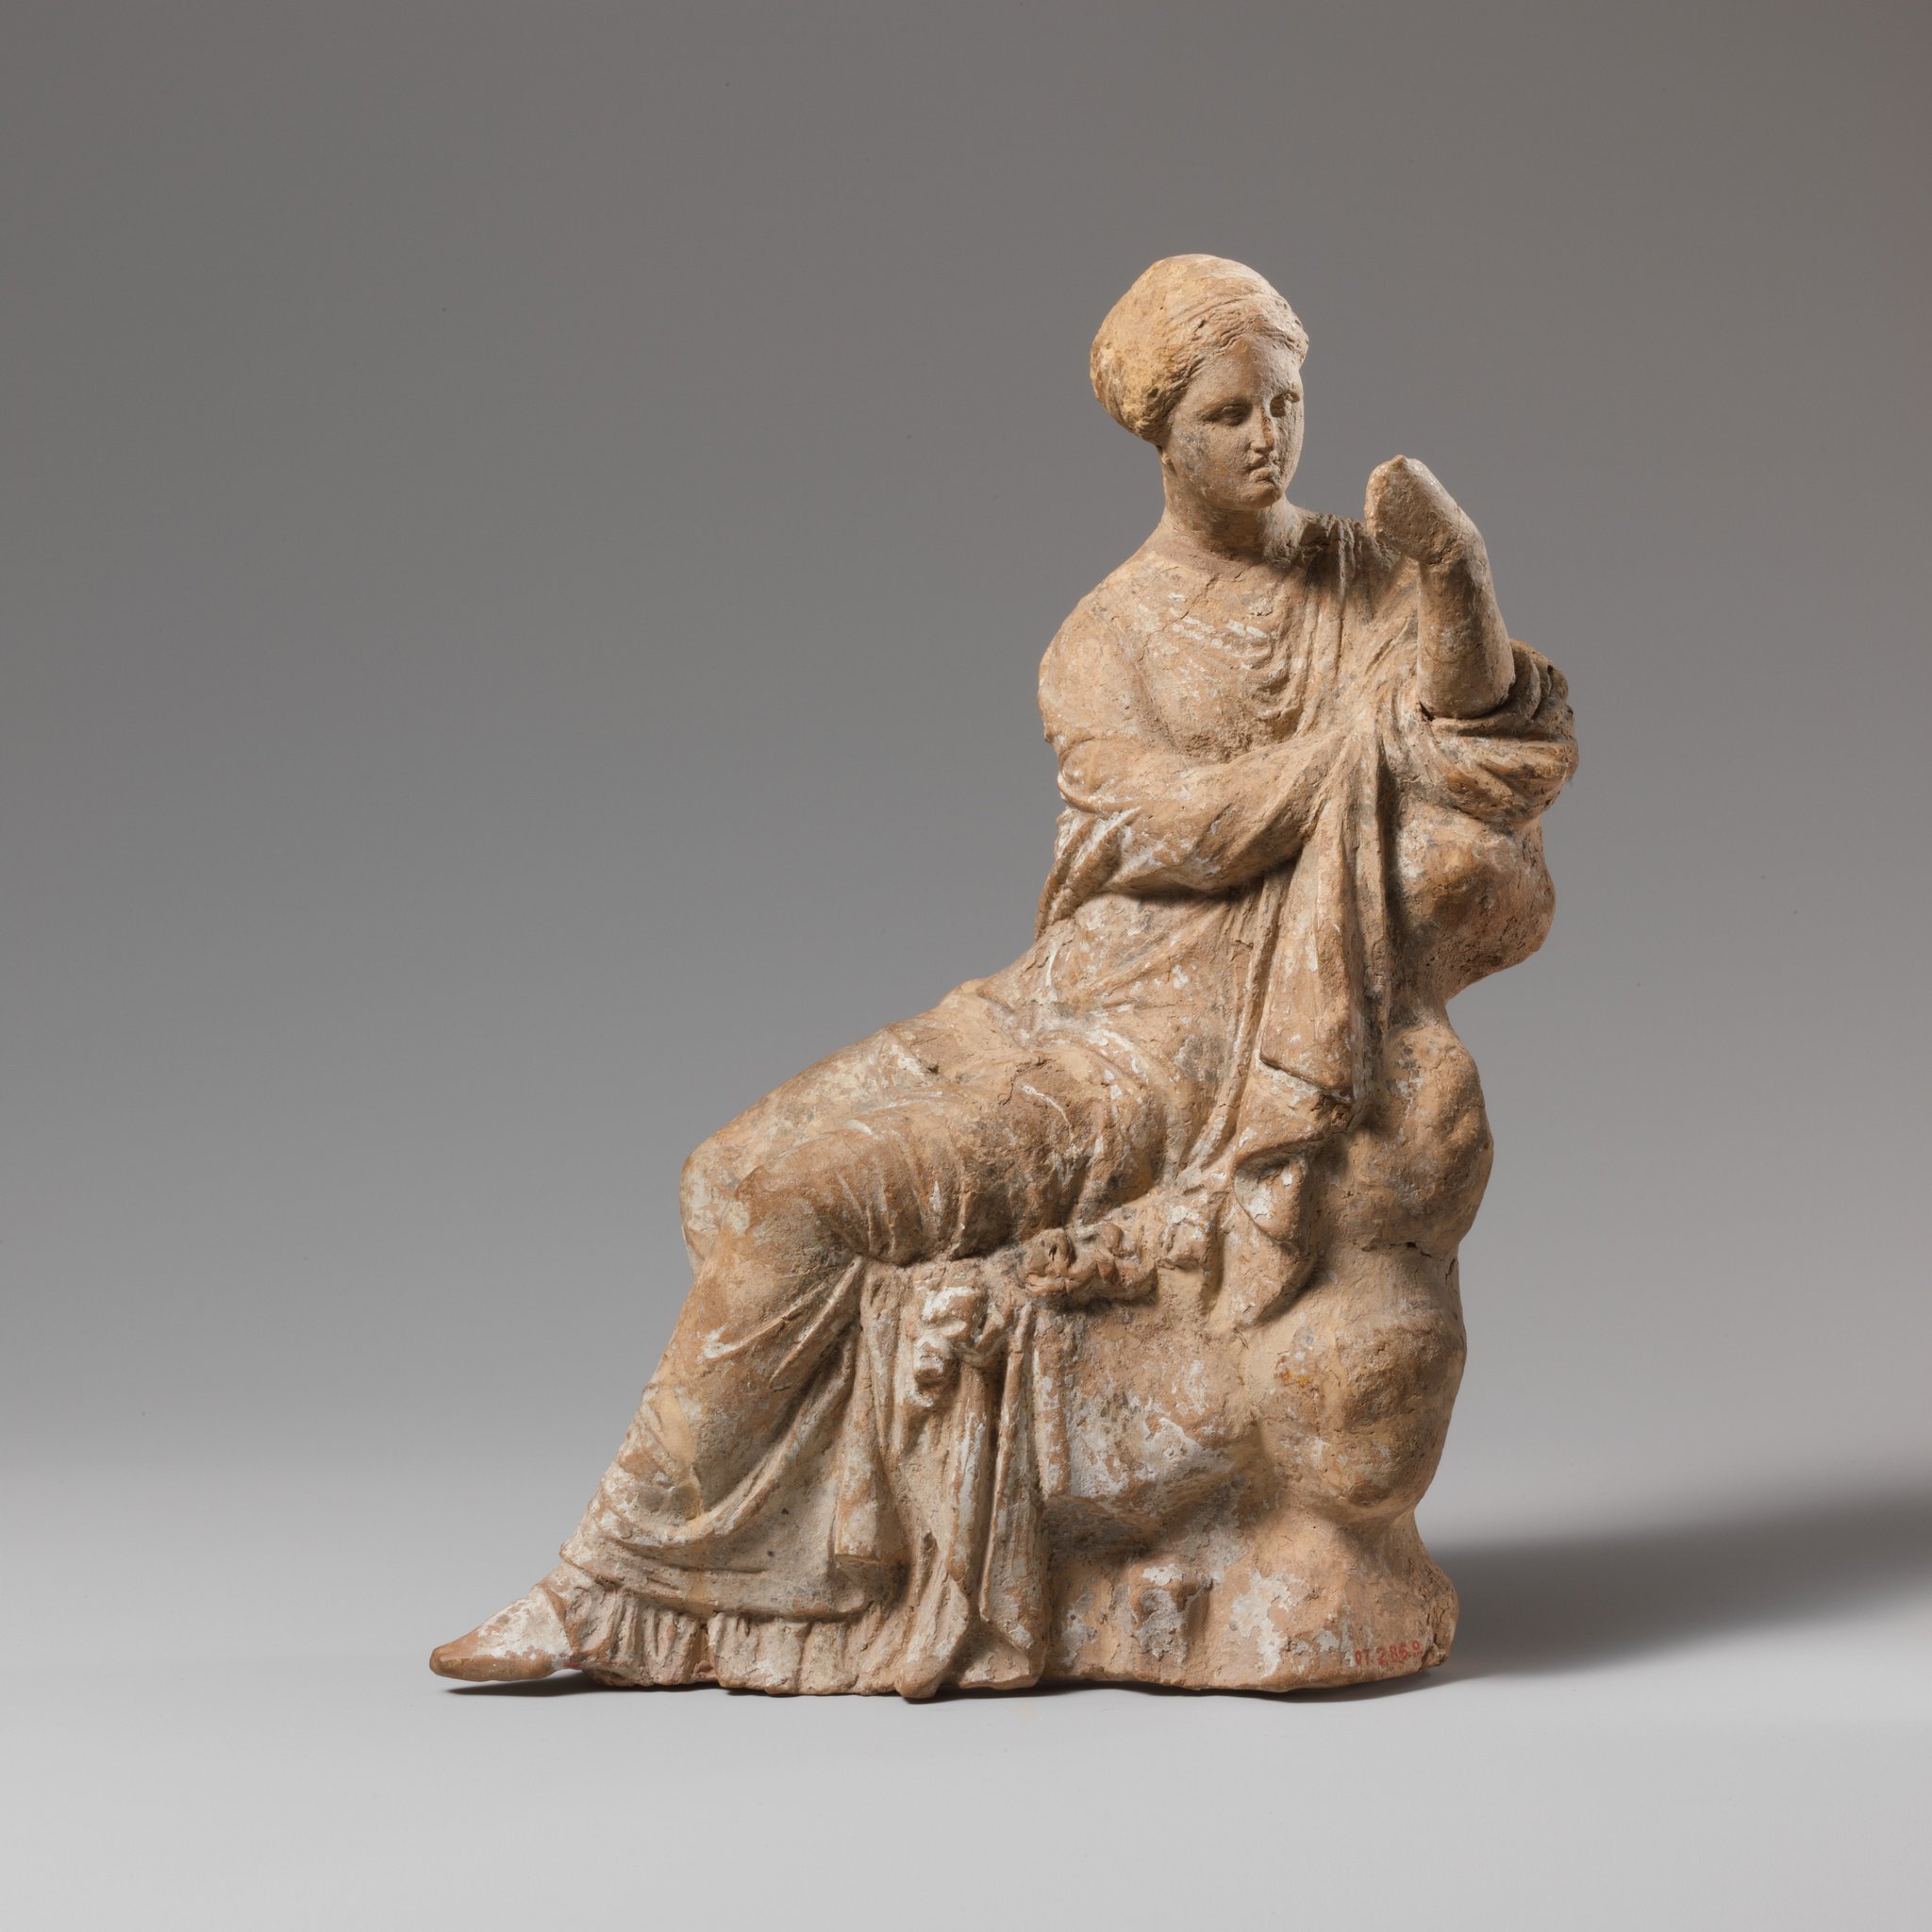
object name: statuette of a woman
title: Terracotta statuette of a woman seated on a rock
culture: greek or south italian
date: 300-201 BCE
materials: terracotta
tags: women